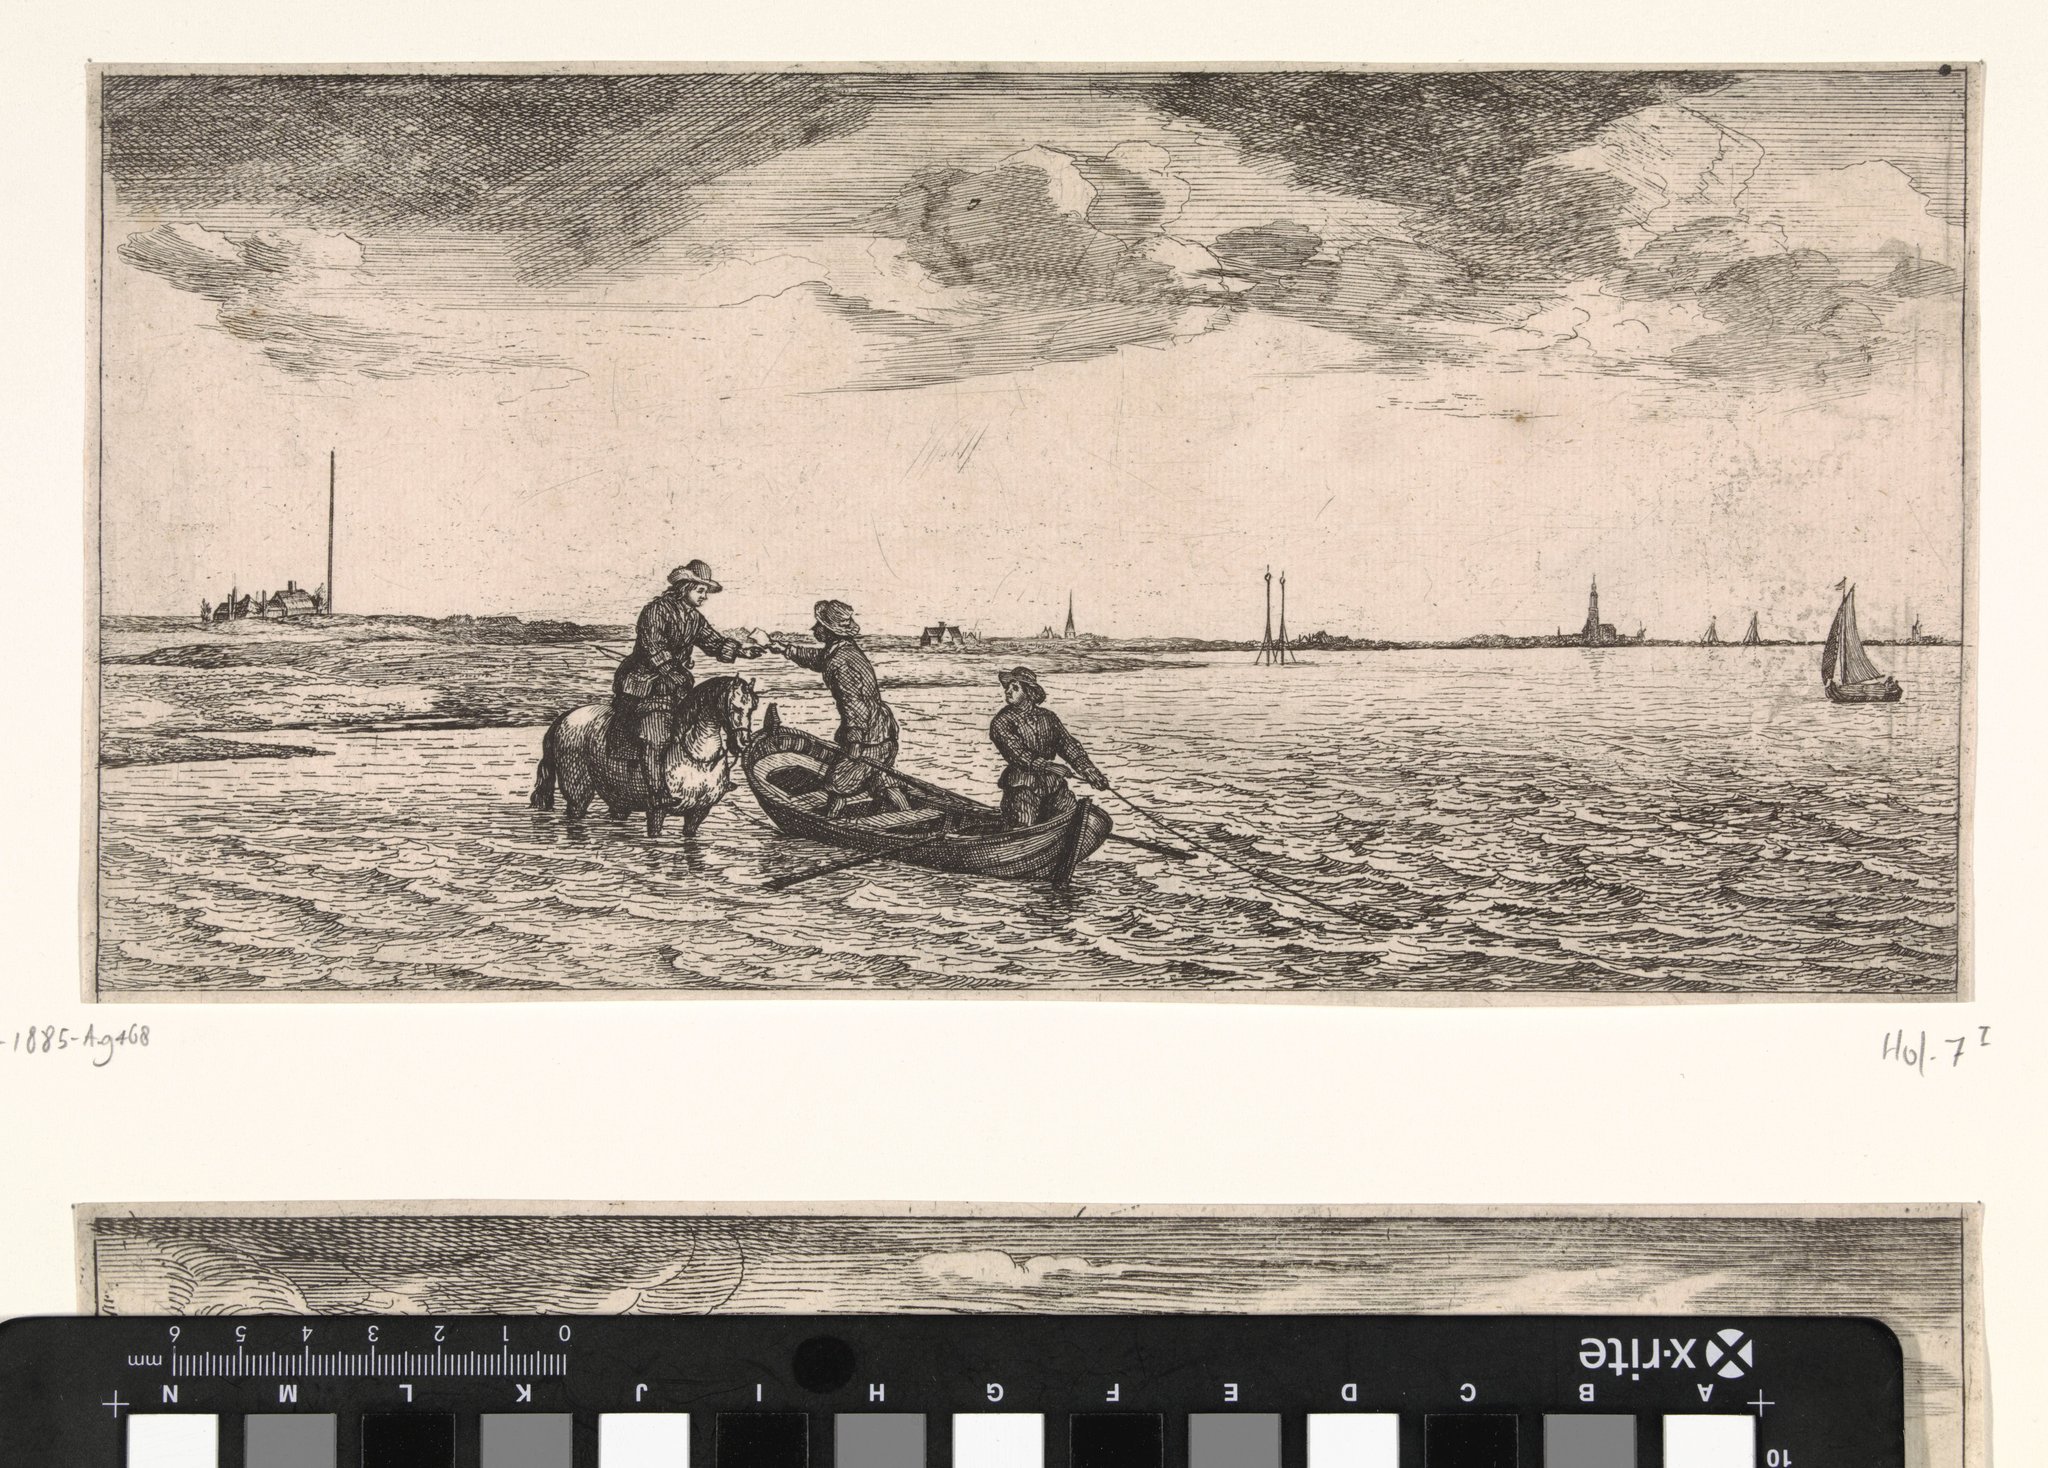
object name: print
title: Ontvangst van post door een postbode te paard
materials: paper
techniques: engraving, etching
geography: rotterdam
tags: postal service, ships (in general), postman, sea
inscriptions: collector's mark: Lugt 1206, collector's mark: Lugt 2228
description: Een postbode te paard waadt door het water en neemt post in ontvangst van twee mannen in een roeiboot.